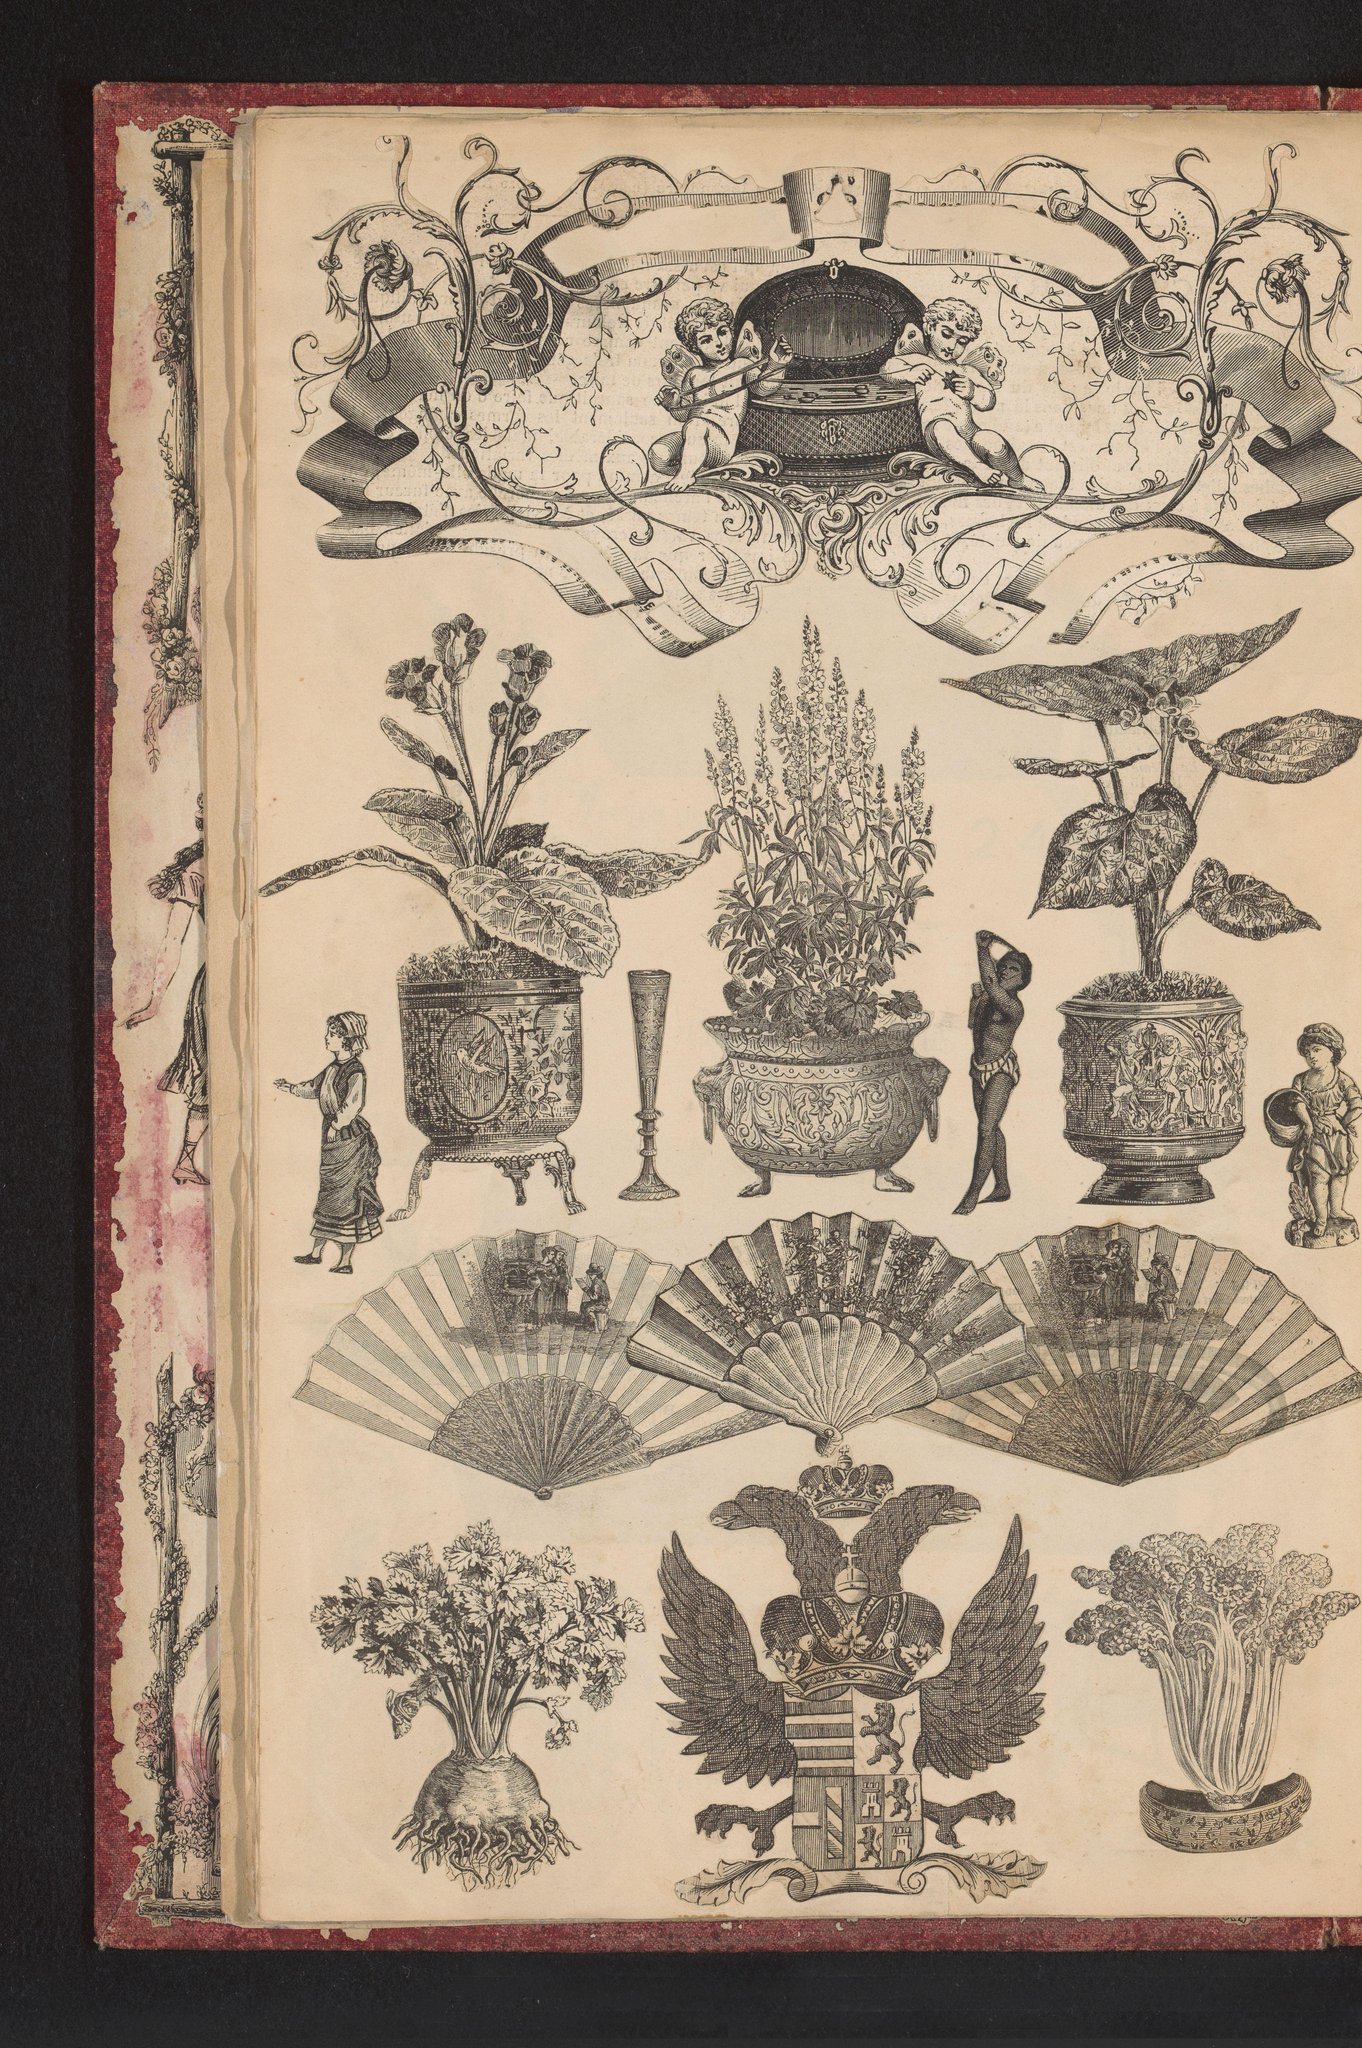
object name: print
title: Collage van uitgeknipte prenten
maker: Anonymous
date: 1870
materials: paper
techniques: engraving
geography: paris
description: Collage van uitgeknipte prenten. Onderdeel van een album met 32 bladen, aan beide zijden beplakt met uitgeknipte prenten, vermoedelijk afkomstig uit 19e-eeuwse tijdschiften.